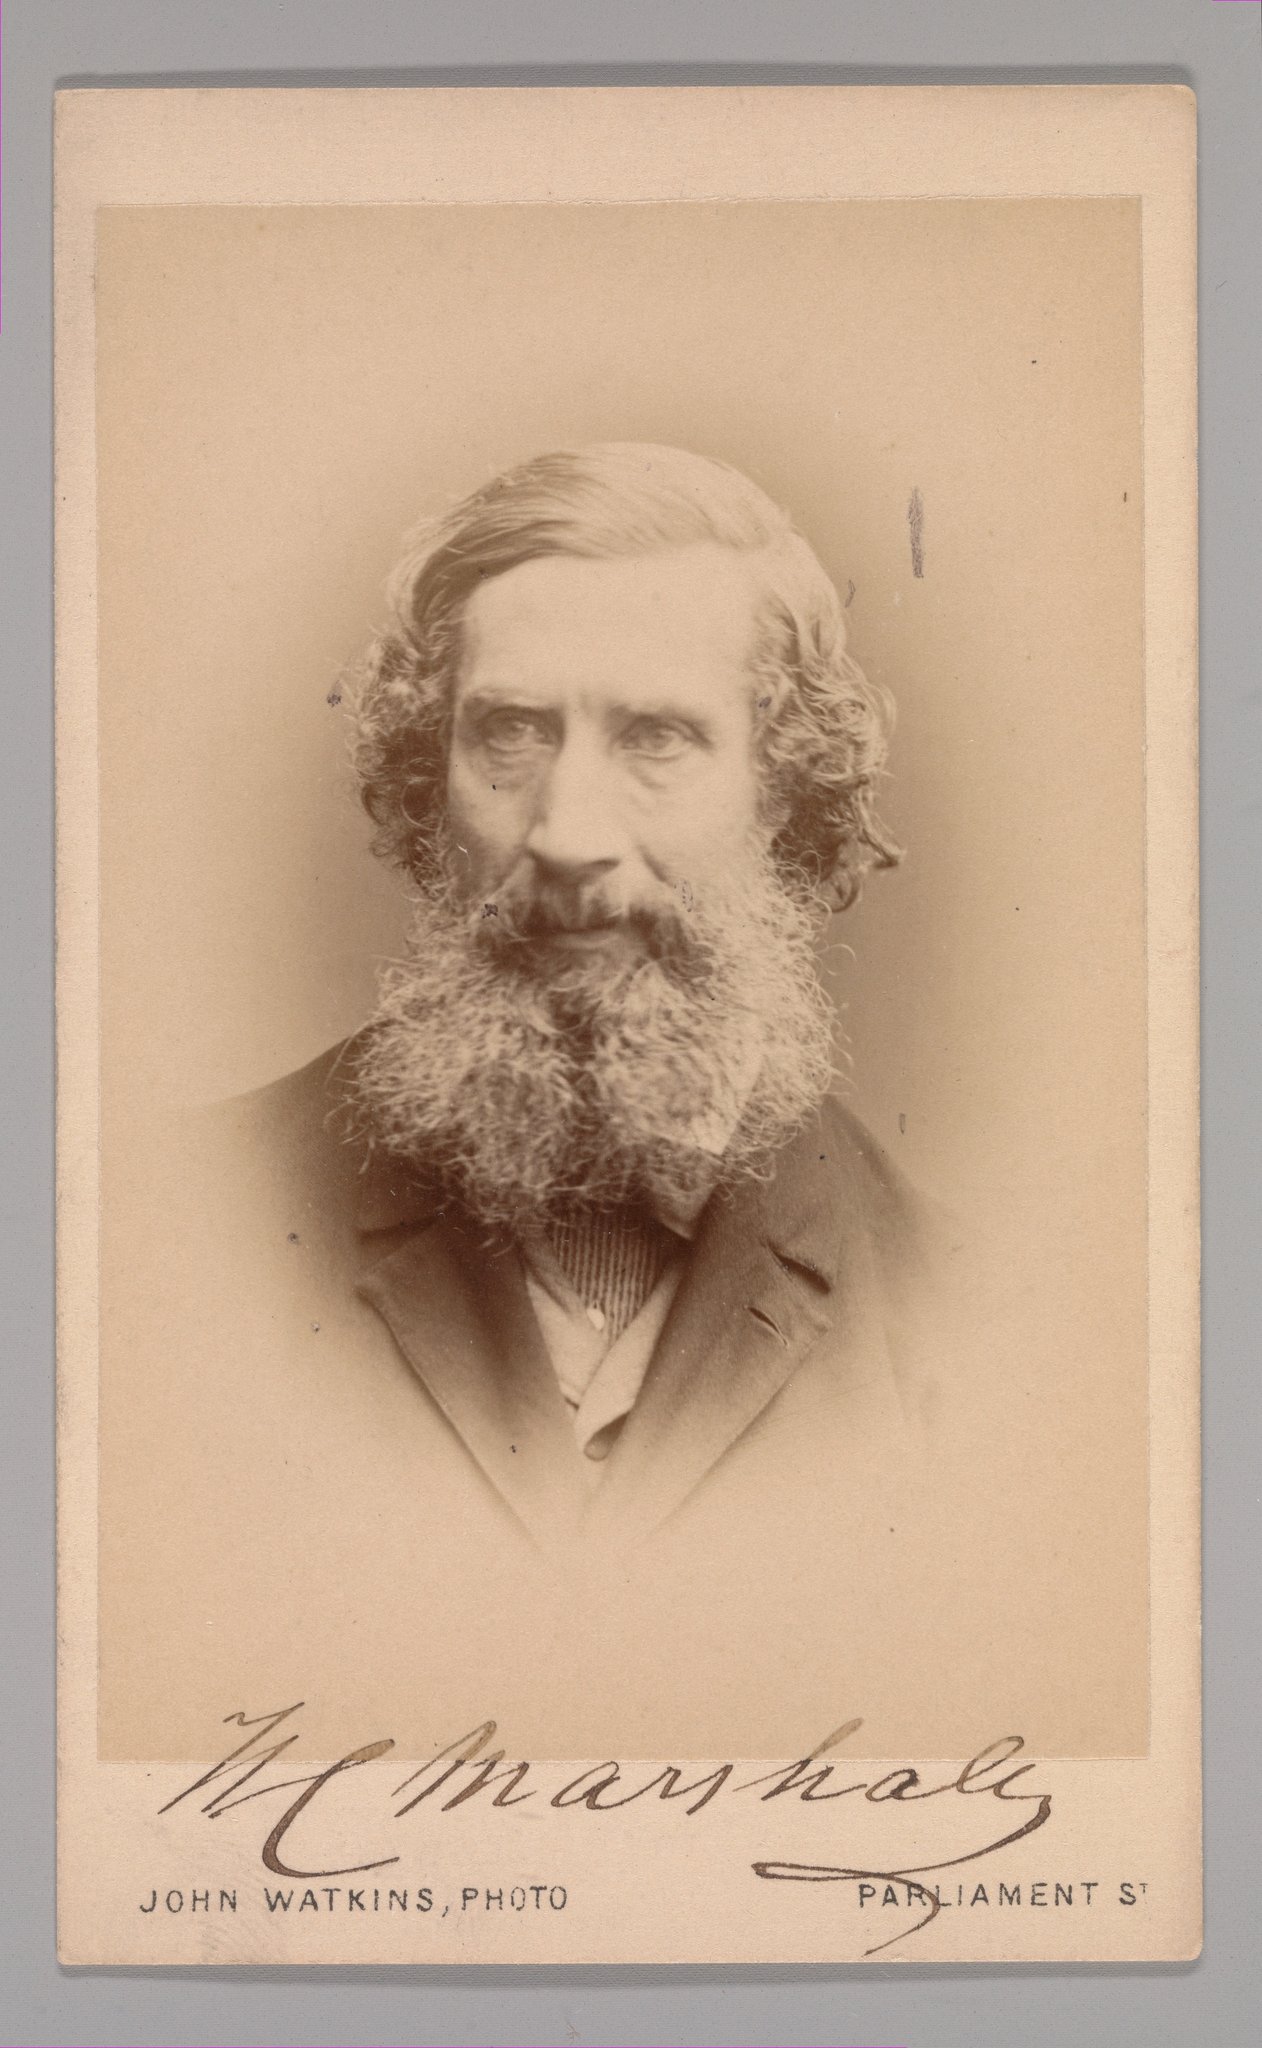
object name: carte de visite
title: [William Calder Marshall]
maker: john and charles watkins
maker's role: photography studio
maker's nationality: british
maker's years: 1840-1875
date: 1860-1869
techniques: albumen silver print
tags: men,portraits